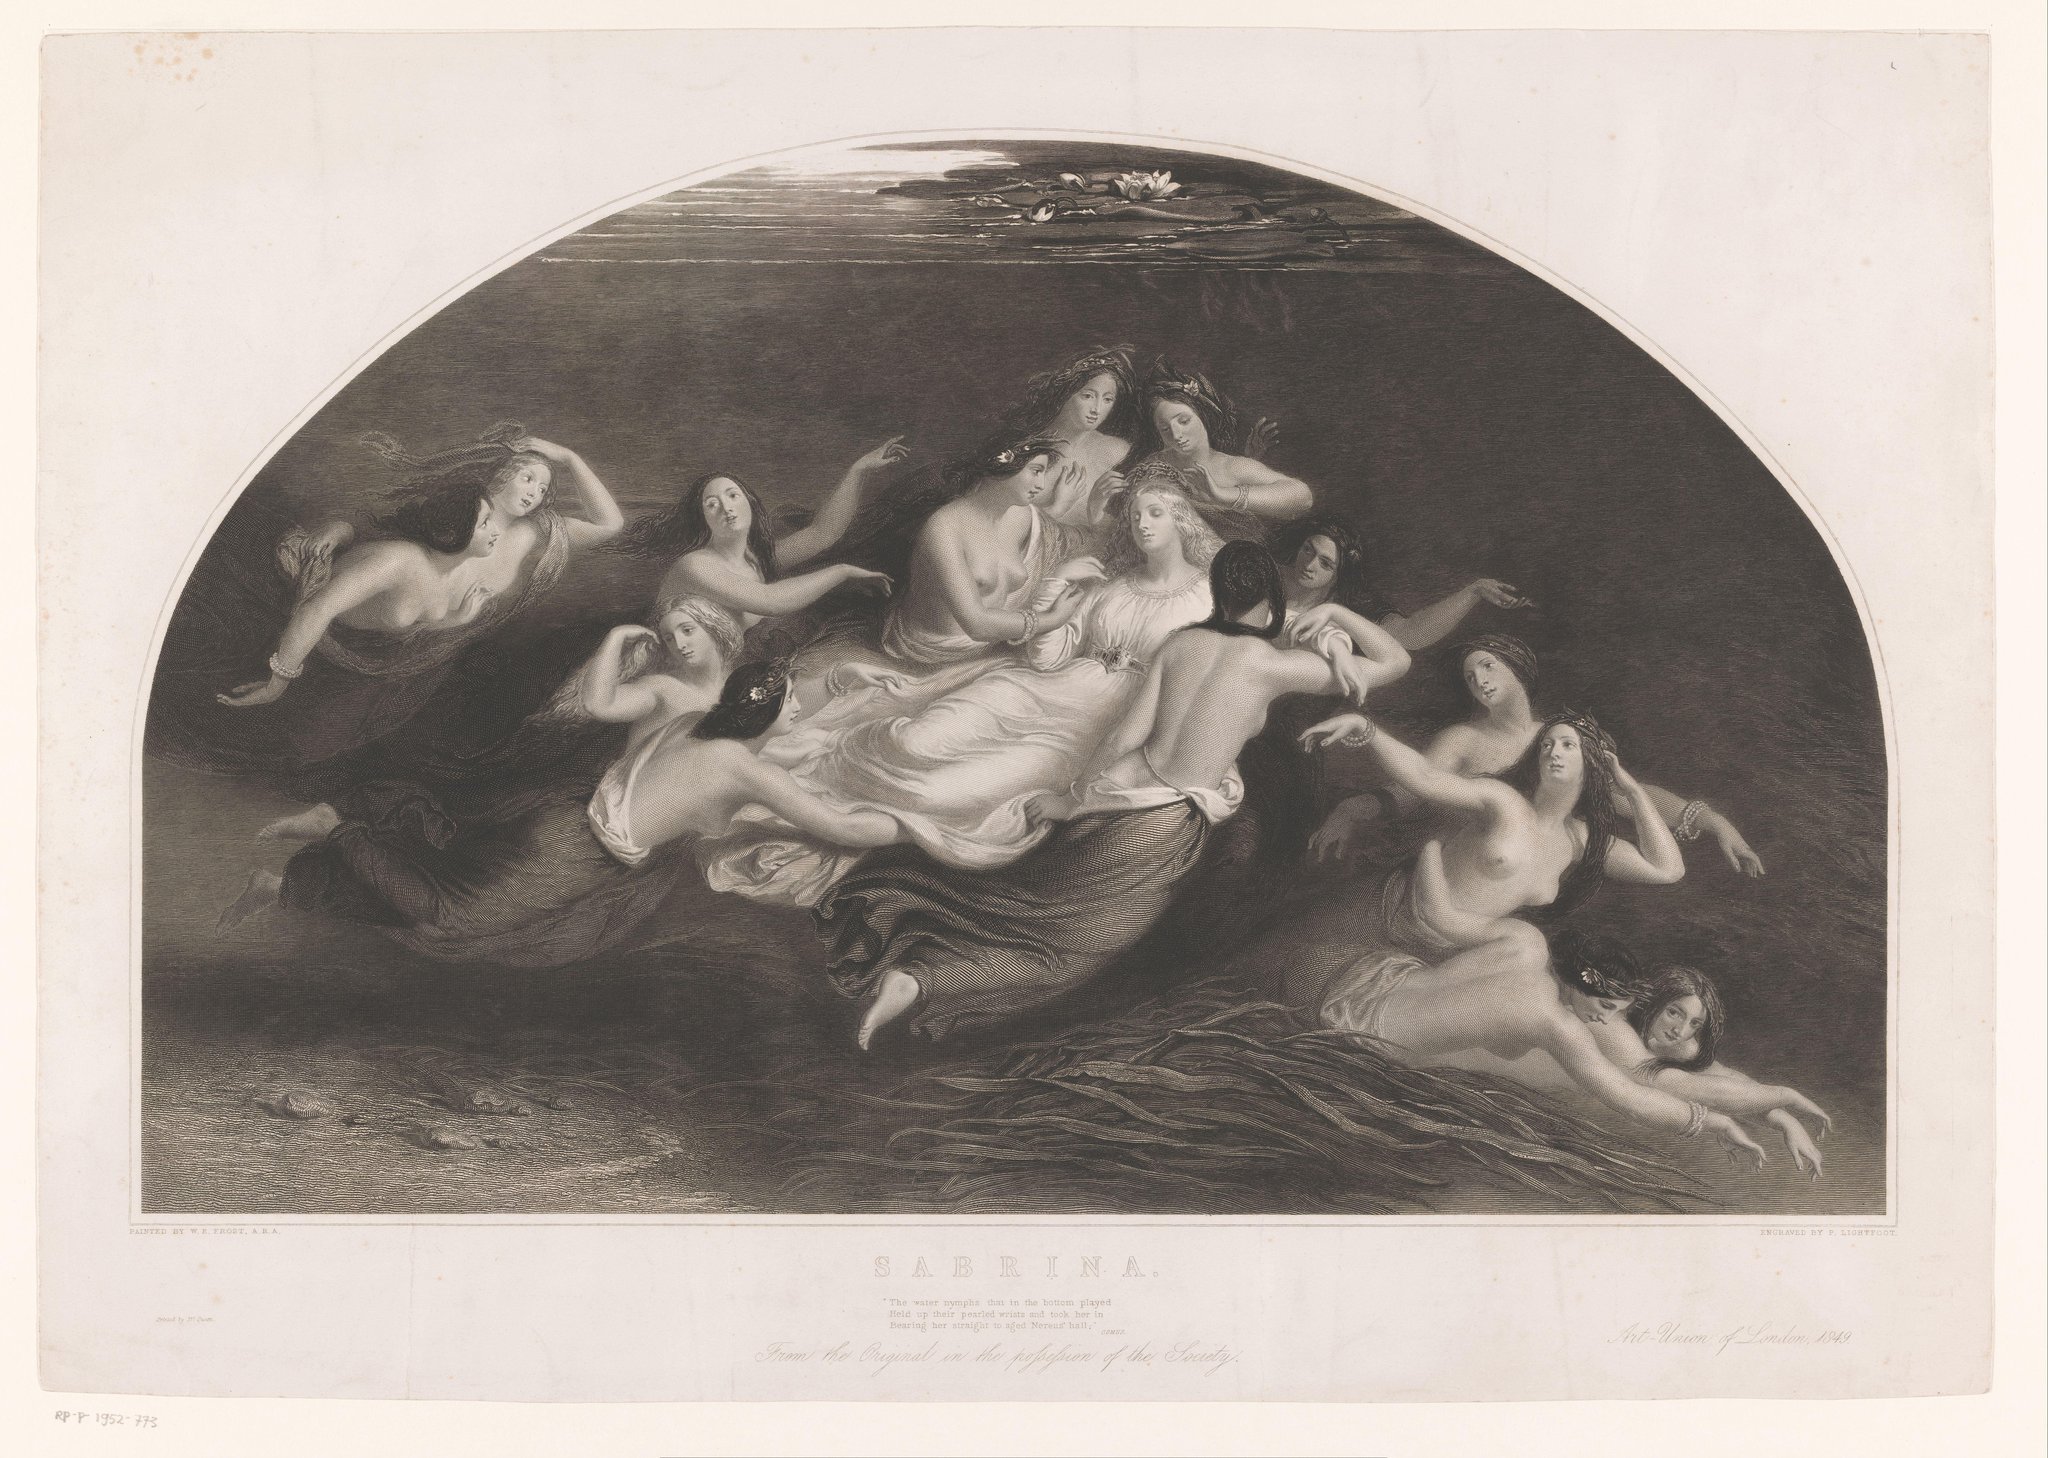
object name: print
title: Sabrina en de nimfen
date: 1849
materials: paper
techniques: engraving, etching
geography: london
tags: nymphs (in general); 'ninfe in commune' (ripa)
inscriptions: collector's mark: Lugt 2228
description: Geïnspireerd op het boek 'Comus' uit 1634 door John Milton.